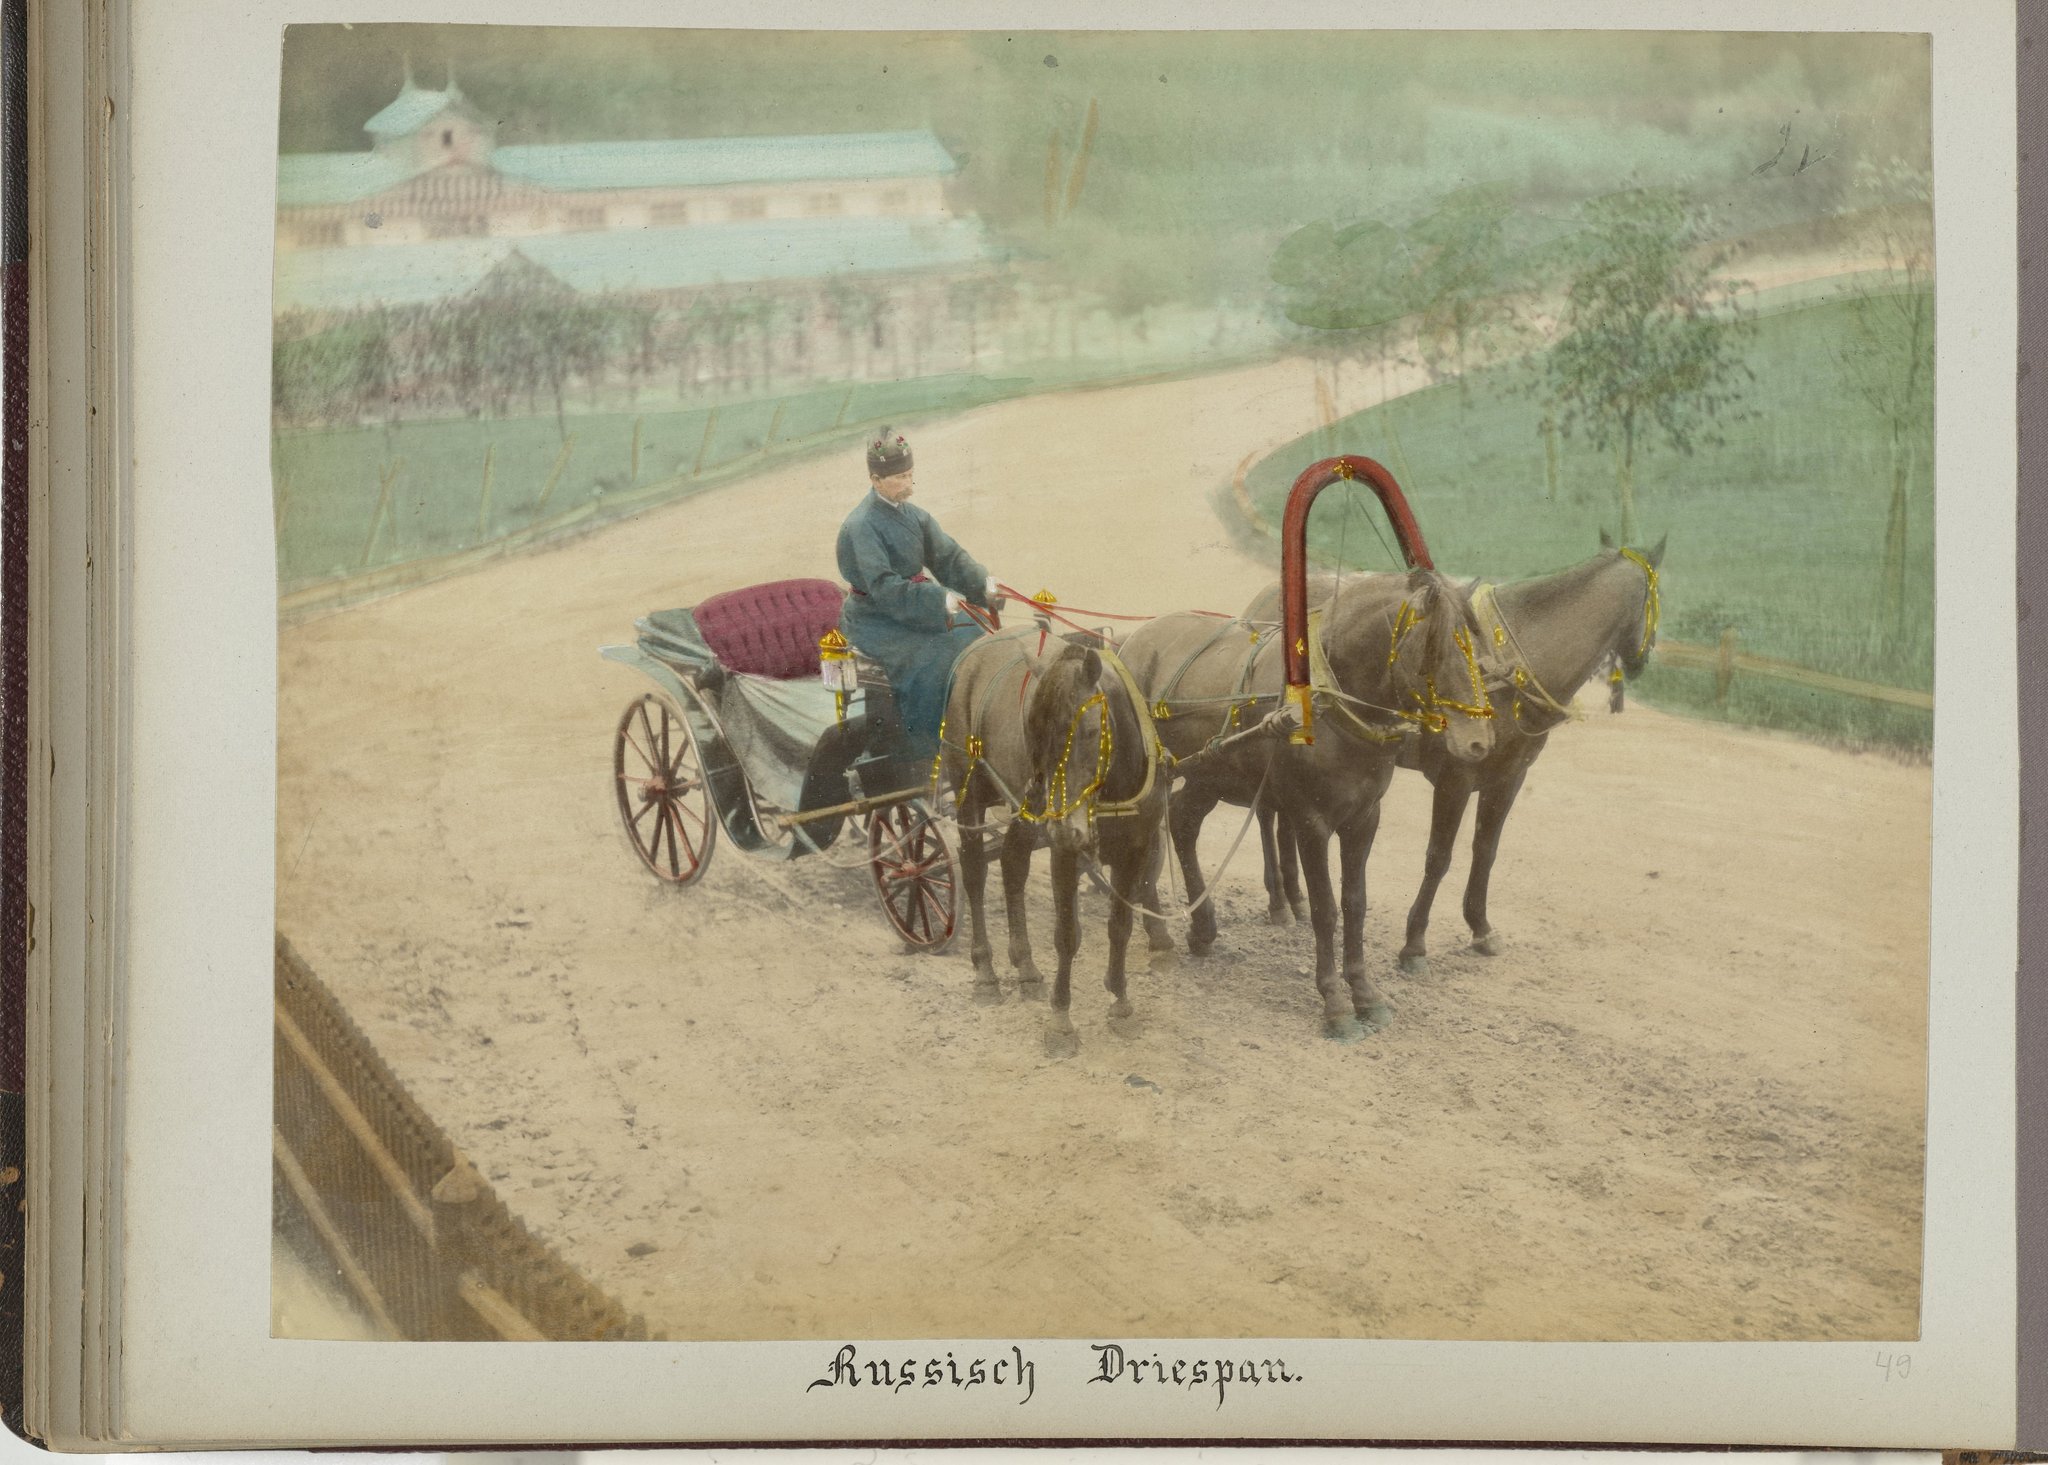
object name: photograph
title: Russisch driespan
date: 1898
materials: paper, photographic support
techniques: albumen print